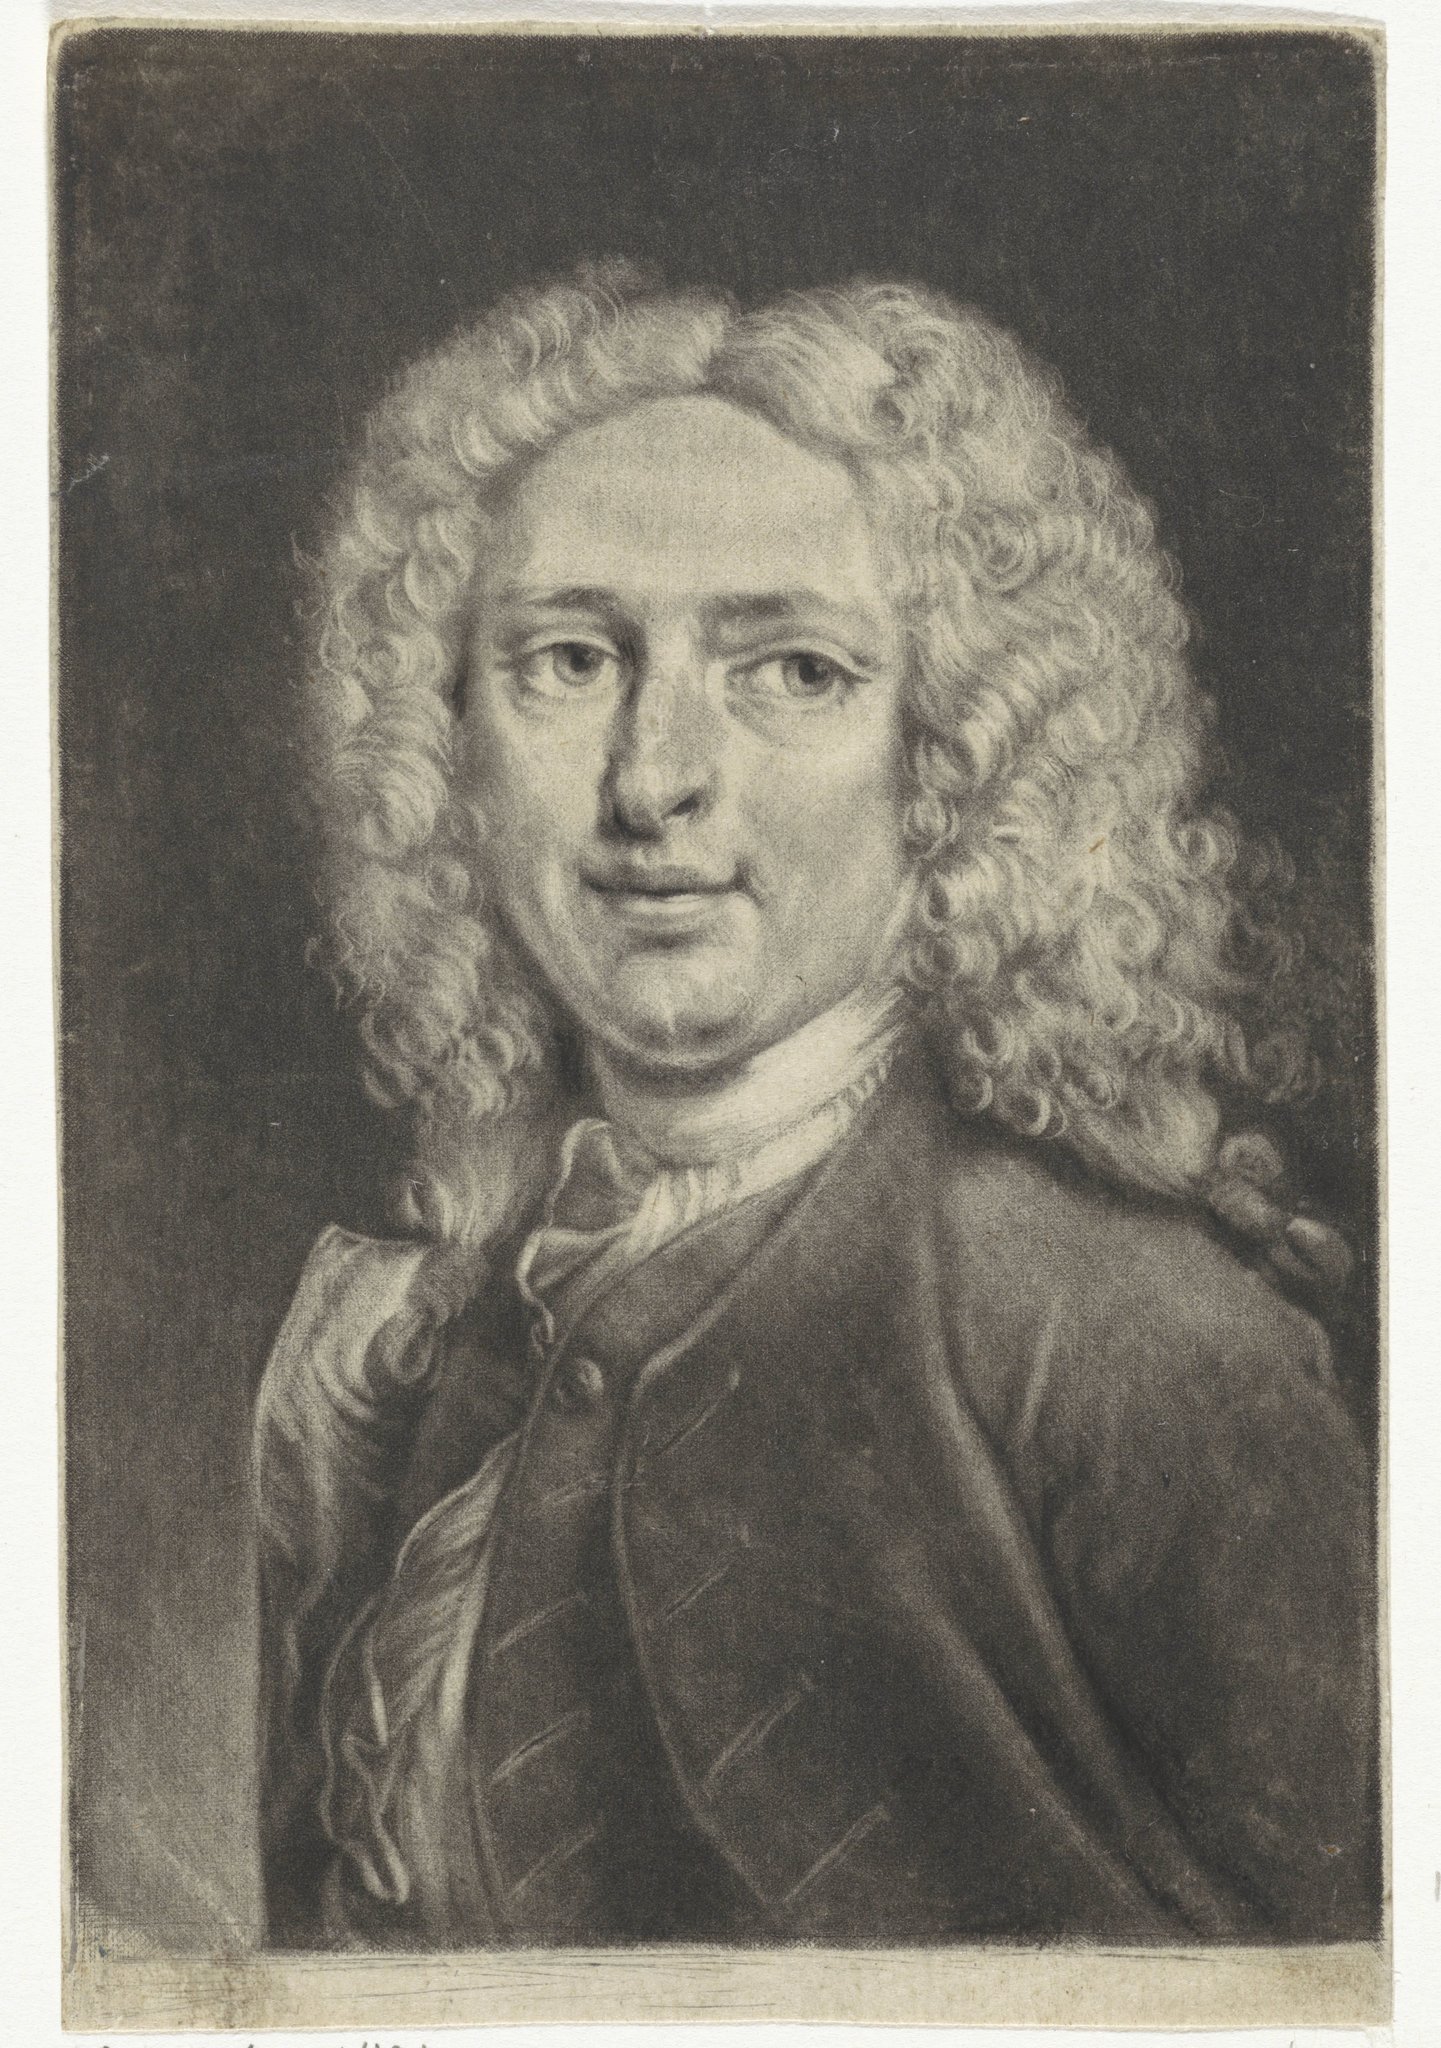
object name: print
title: Portret van de schilder en prentmaker Cornelis Troost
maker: arnout rentinck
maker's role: draughtsman, print maker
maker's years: 1712-1774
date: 1722-1775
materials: paper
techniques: mezzotint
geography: amsterdam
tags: amsterdam, painter, print maker, draughtsman, cornelis troost, portrait, self-portrait of artist, wig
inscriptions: collector's mark: Lugt 2228, collector's mark: Lugt 2760